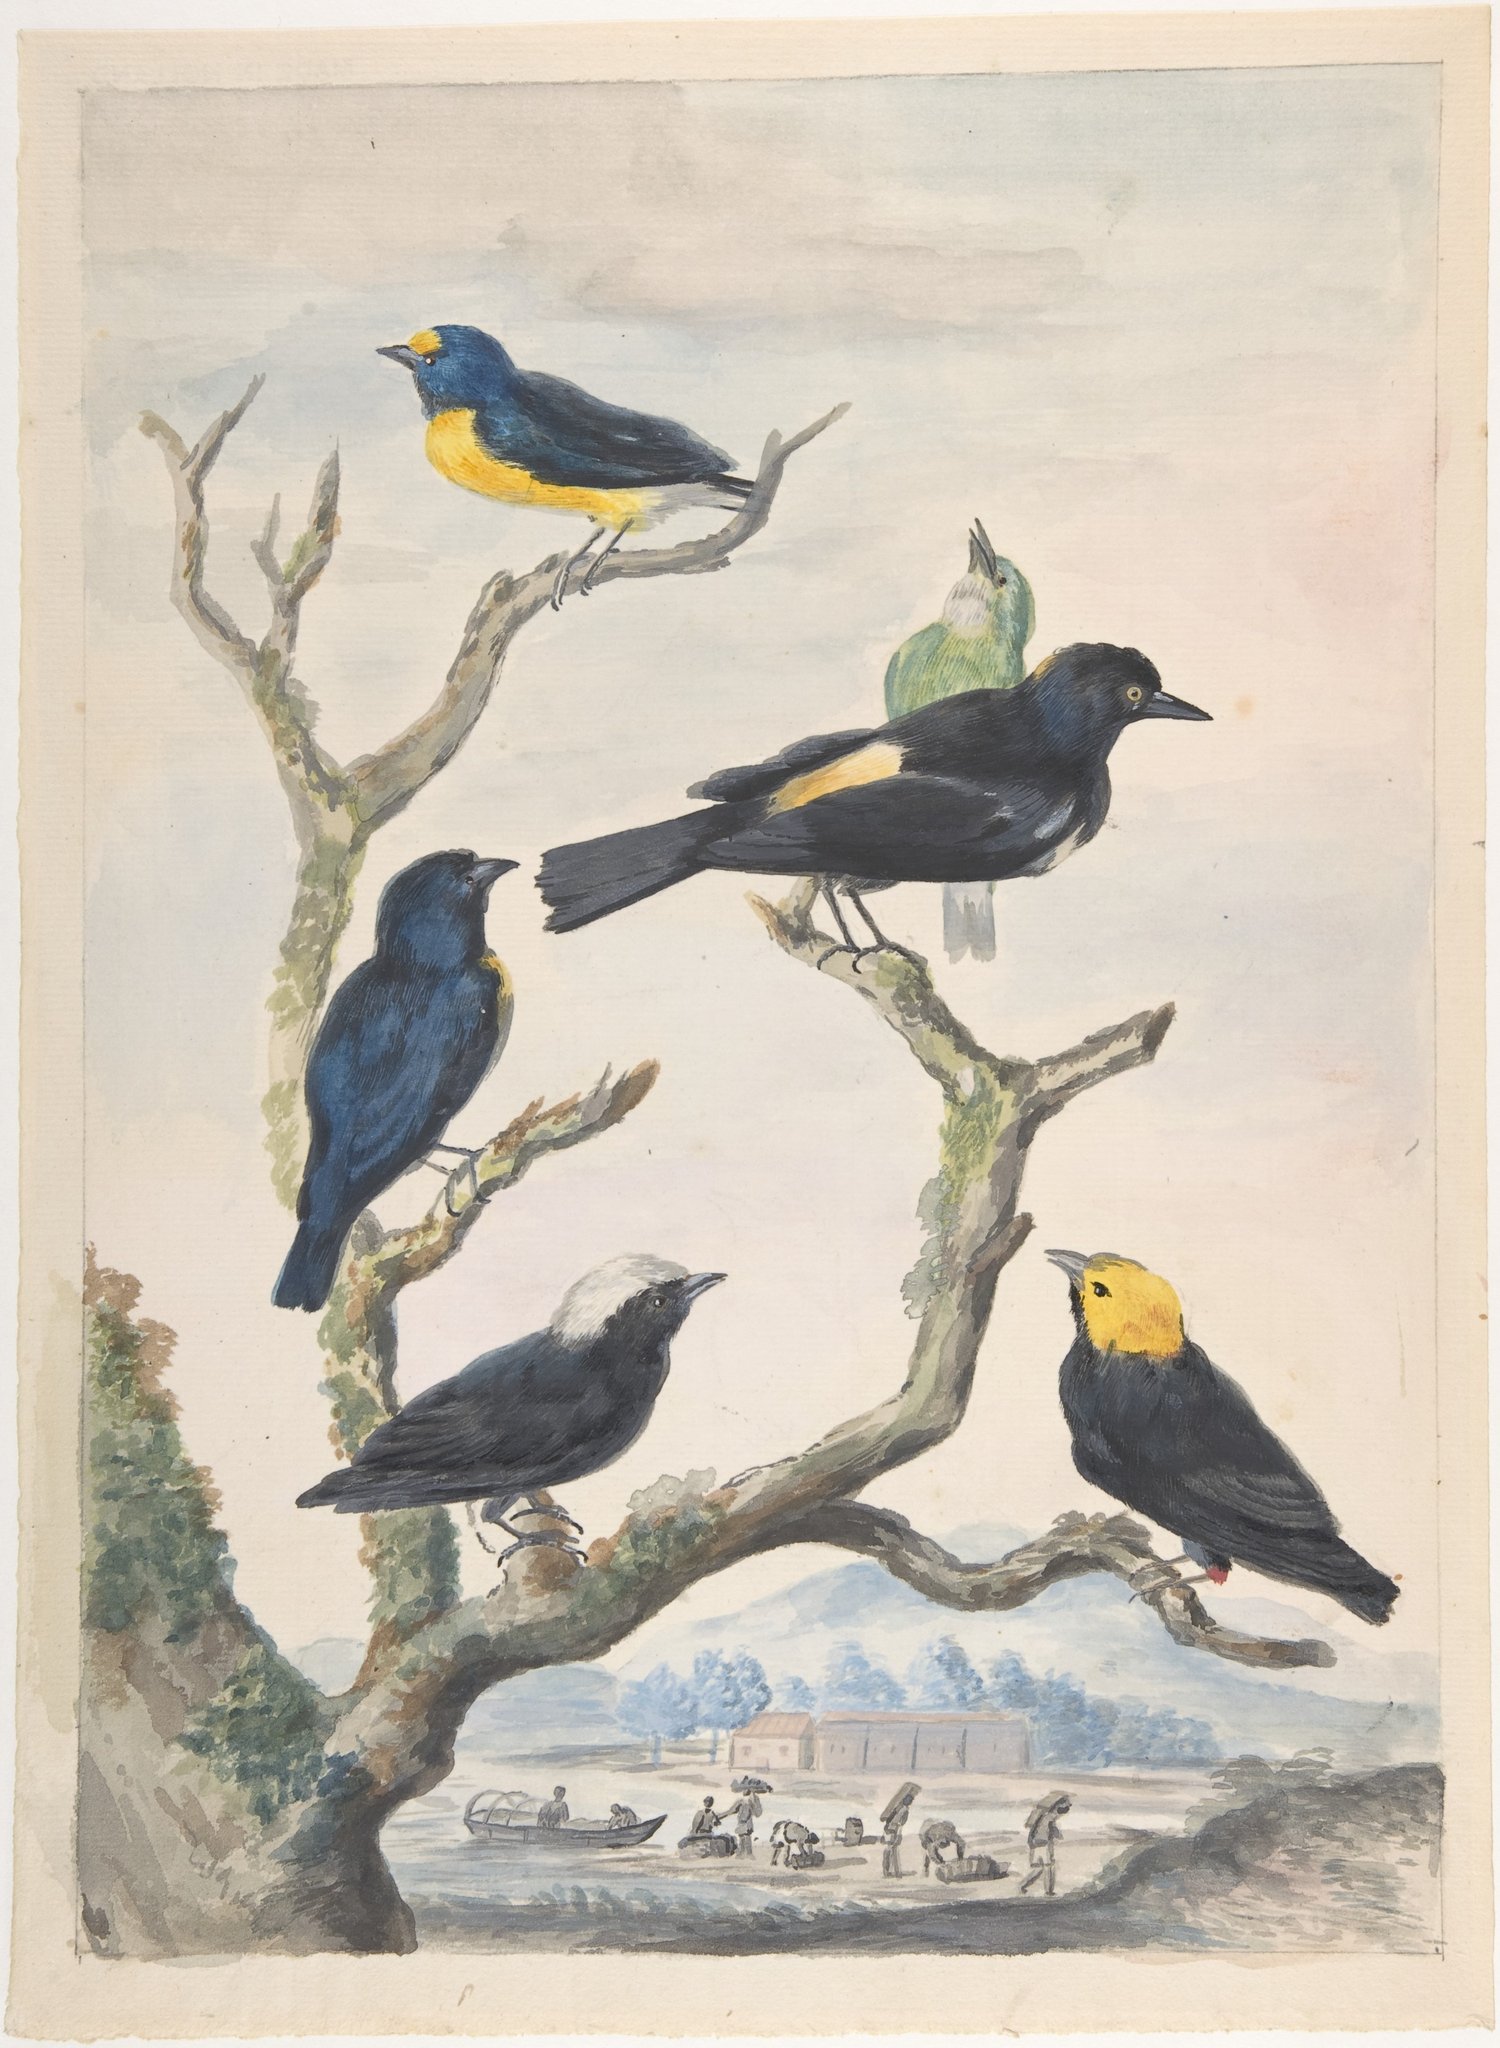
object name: drawing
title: Six South American Birds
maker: abraham meertens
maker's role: artist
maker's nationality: dutch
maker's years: 1747-1823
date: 1734-1833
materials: graphite, watercolor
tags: birds,trees